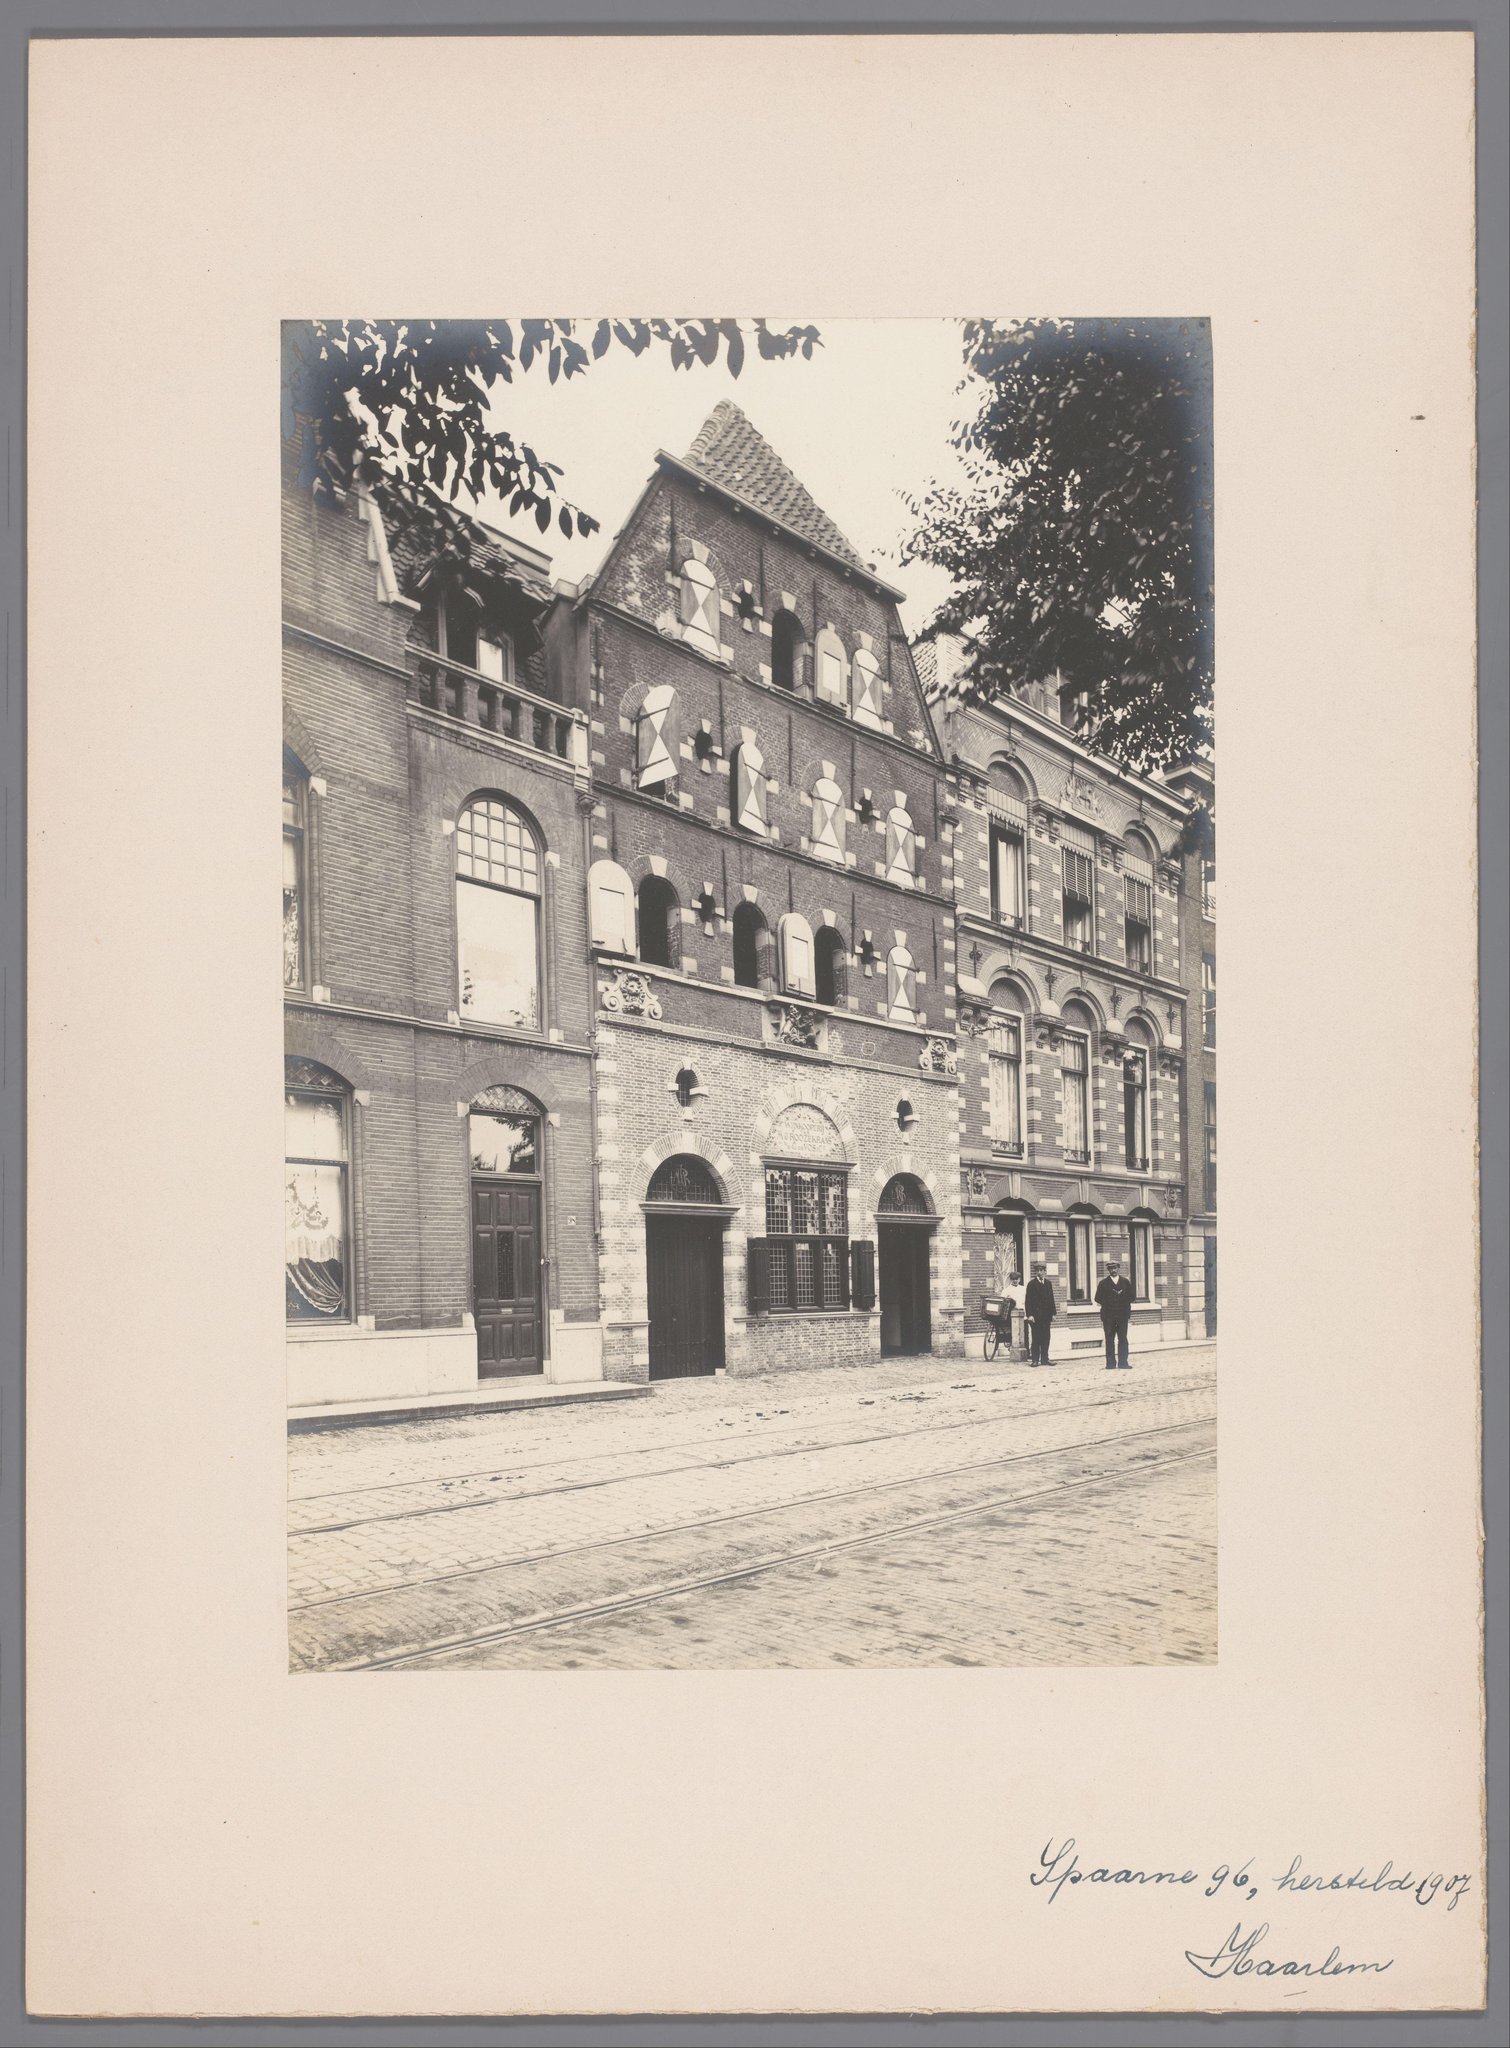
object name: photograph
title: Gezicht op Spaarne 96 te Haarlem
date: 1907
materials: cardboard, photographic support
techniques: gelatin silver print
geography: spaarne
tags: shop, store, façade (of house or building)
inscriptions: annotation: ‘Haarlem/ Huis Spaarne 96/ hersteld 1907 door [...]’, annotation: ‘Spaarne 96, hersteld 1907/ Haarlem’